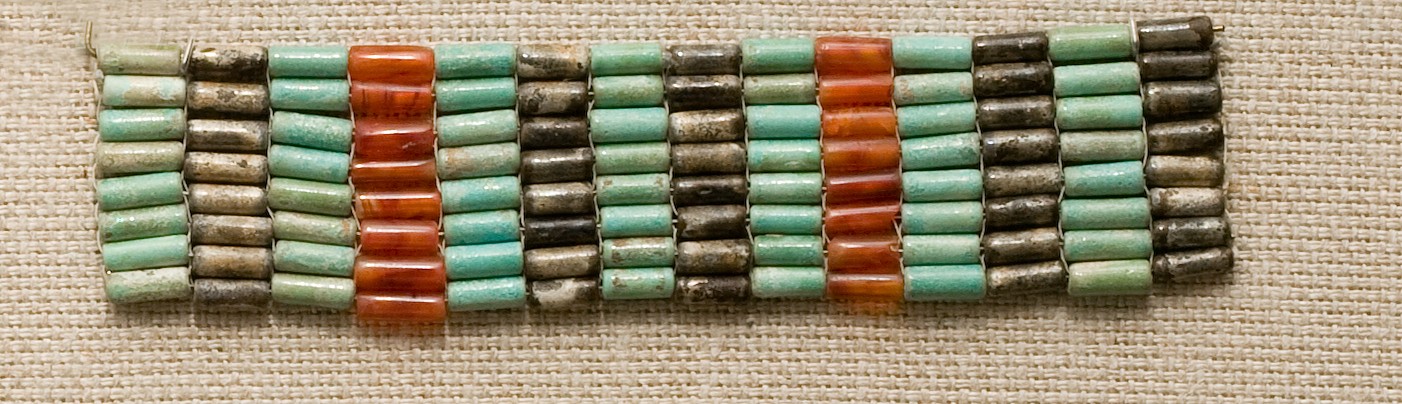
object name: bracelet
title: Bracelet from mummy of Satsebek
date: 1950-1900 BCE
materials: gemstone, faience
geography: egypt